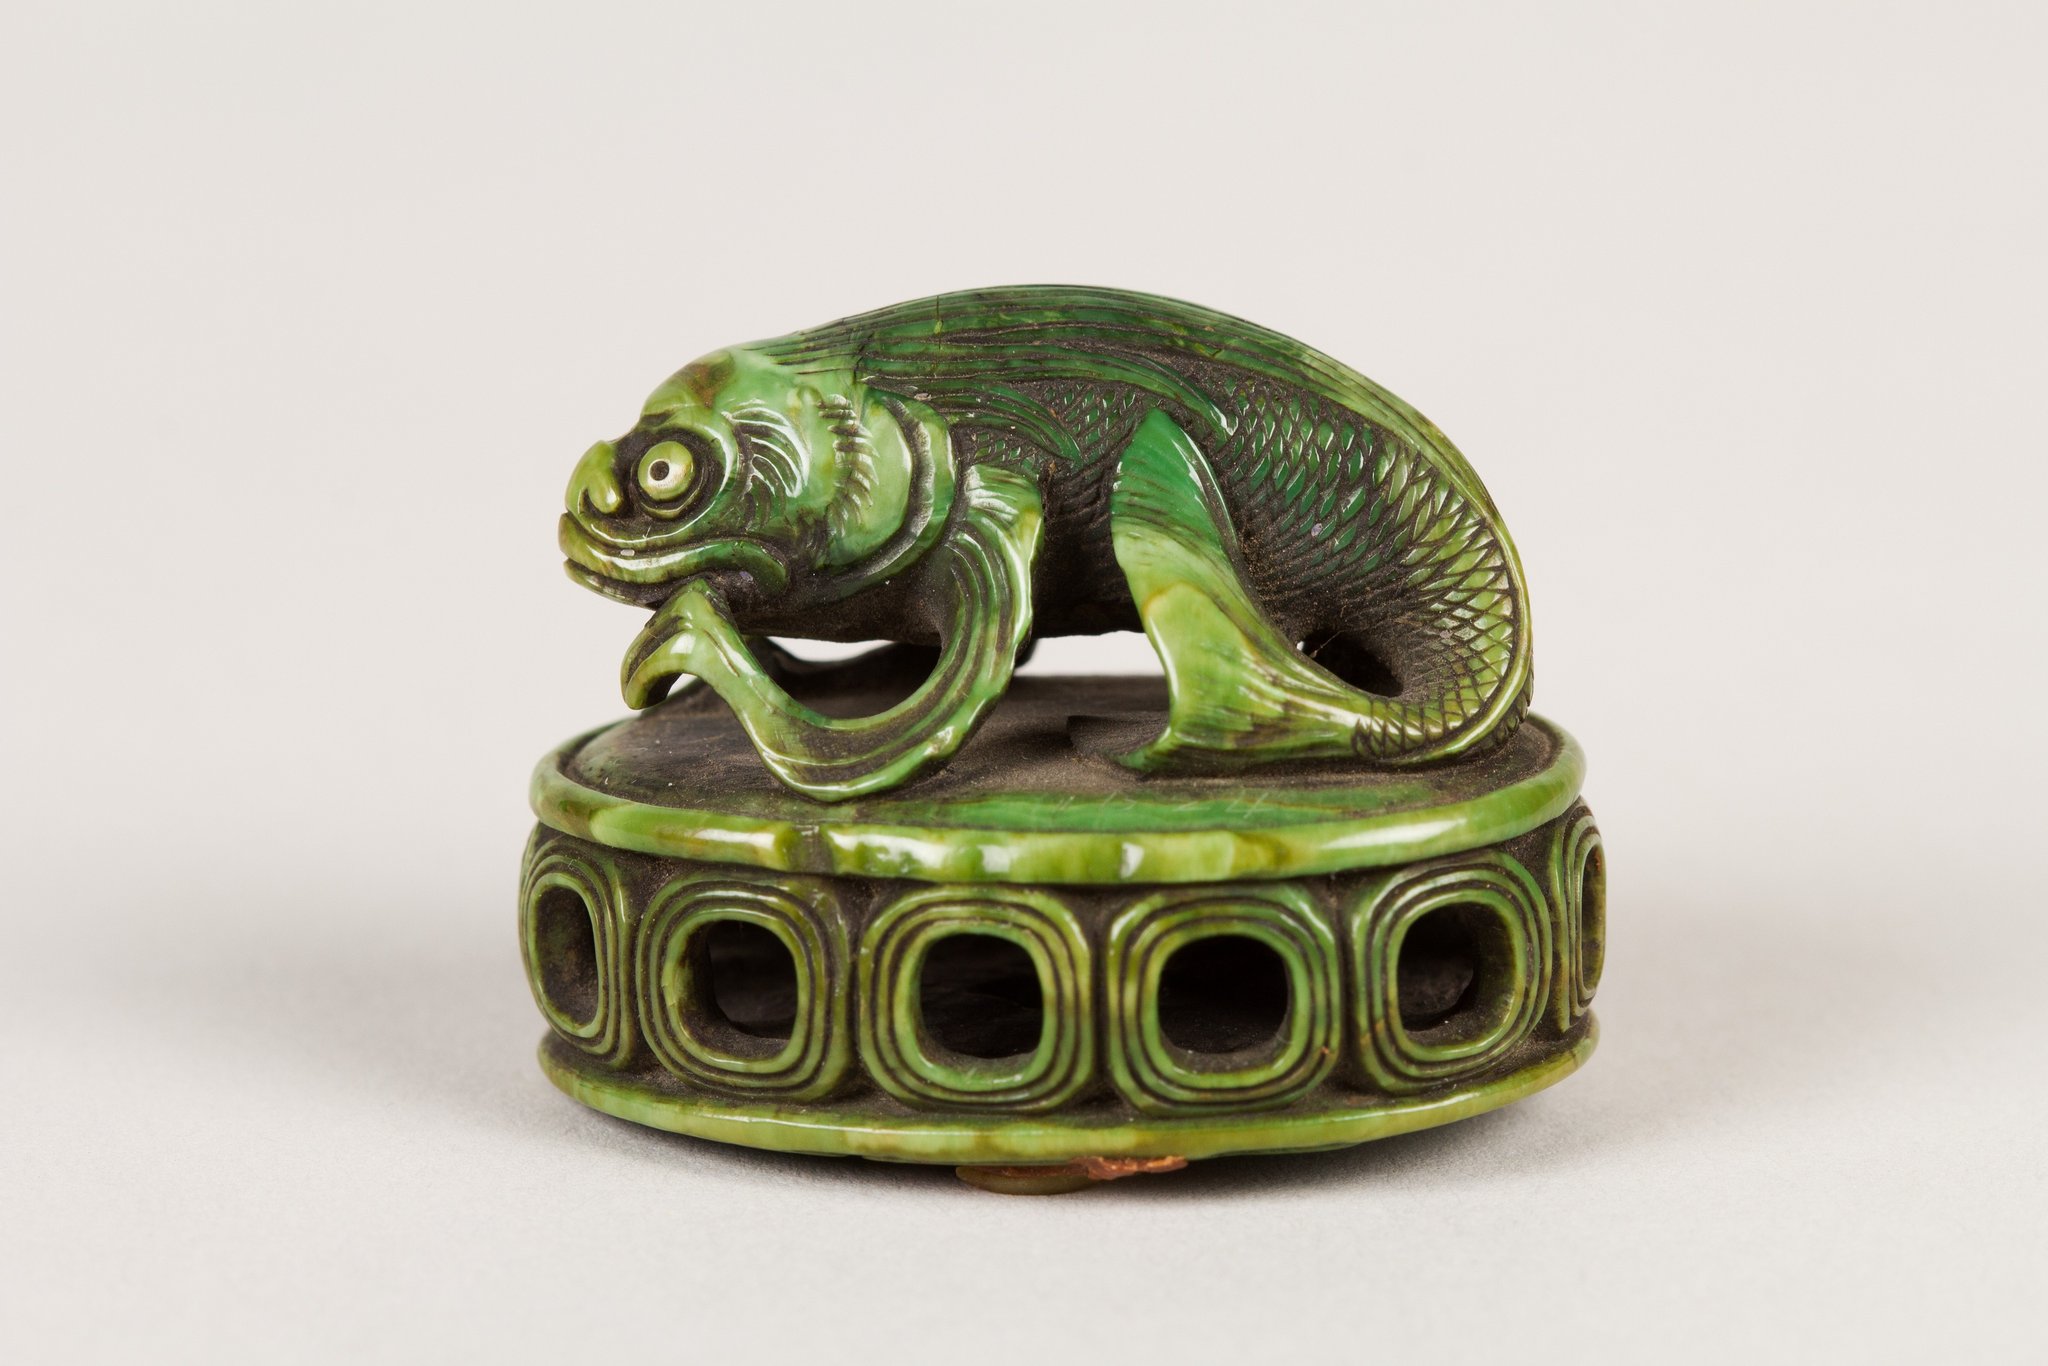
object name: netsuke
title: Netsuke of Fish on a Seal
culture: japanese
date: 1801-1900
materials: ivory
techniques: stain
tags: fish